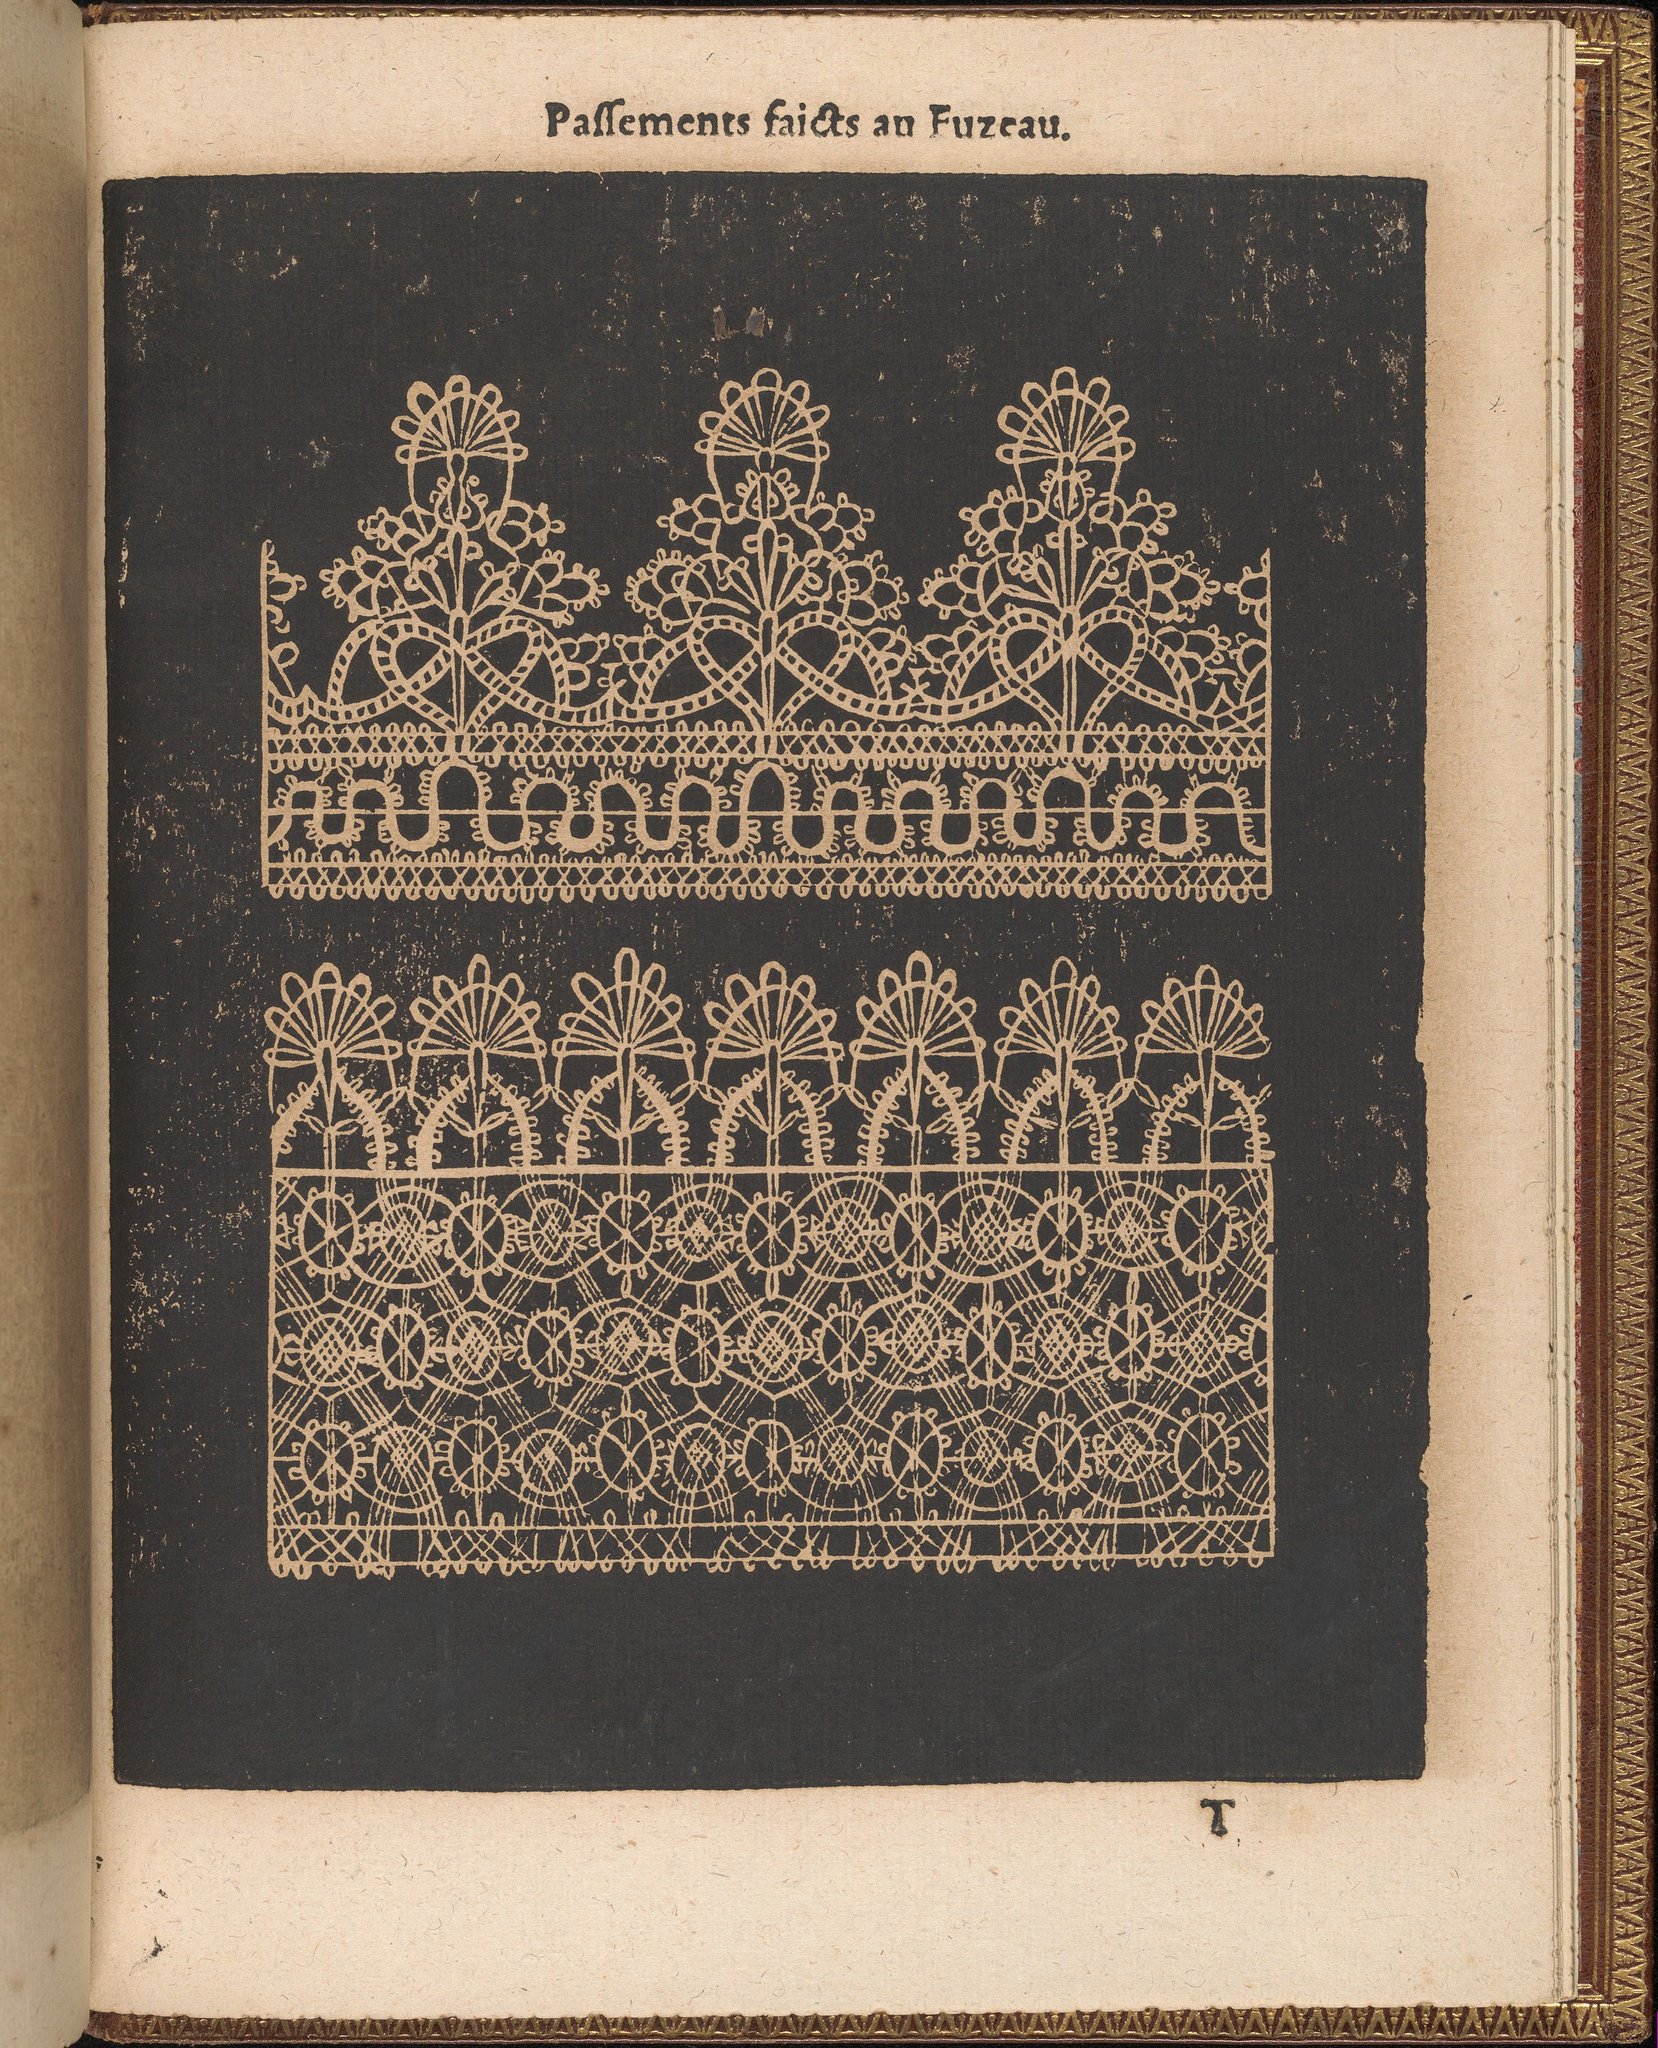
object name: book print ornament architecture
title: La Pratique de l'Aiguille, page 72 (recto)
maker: matthias mignerak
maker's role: author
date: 1605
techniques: woodcut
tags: ornament